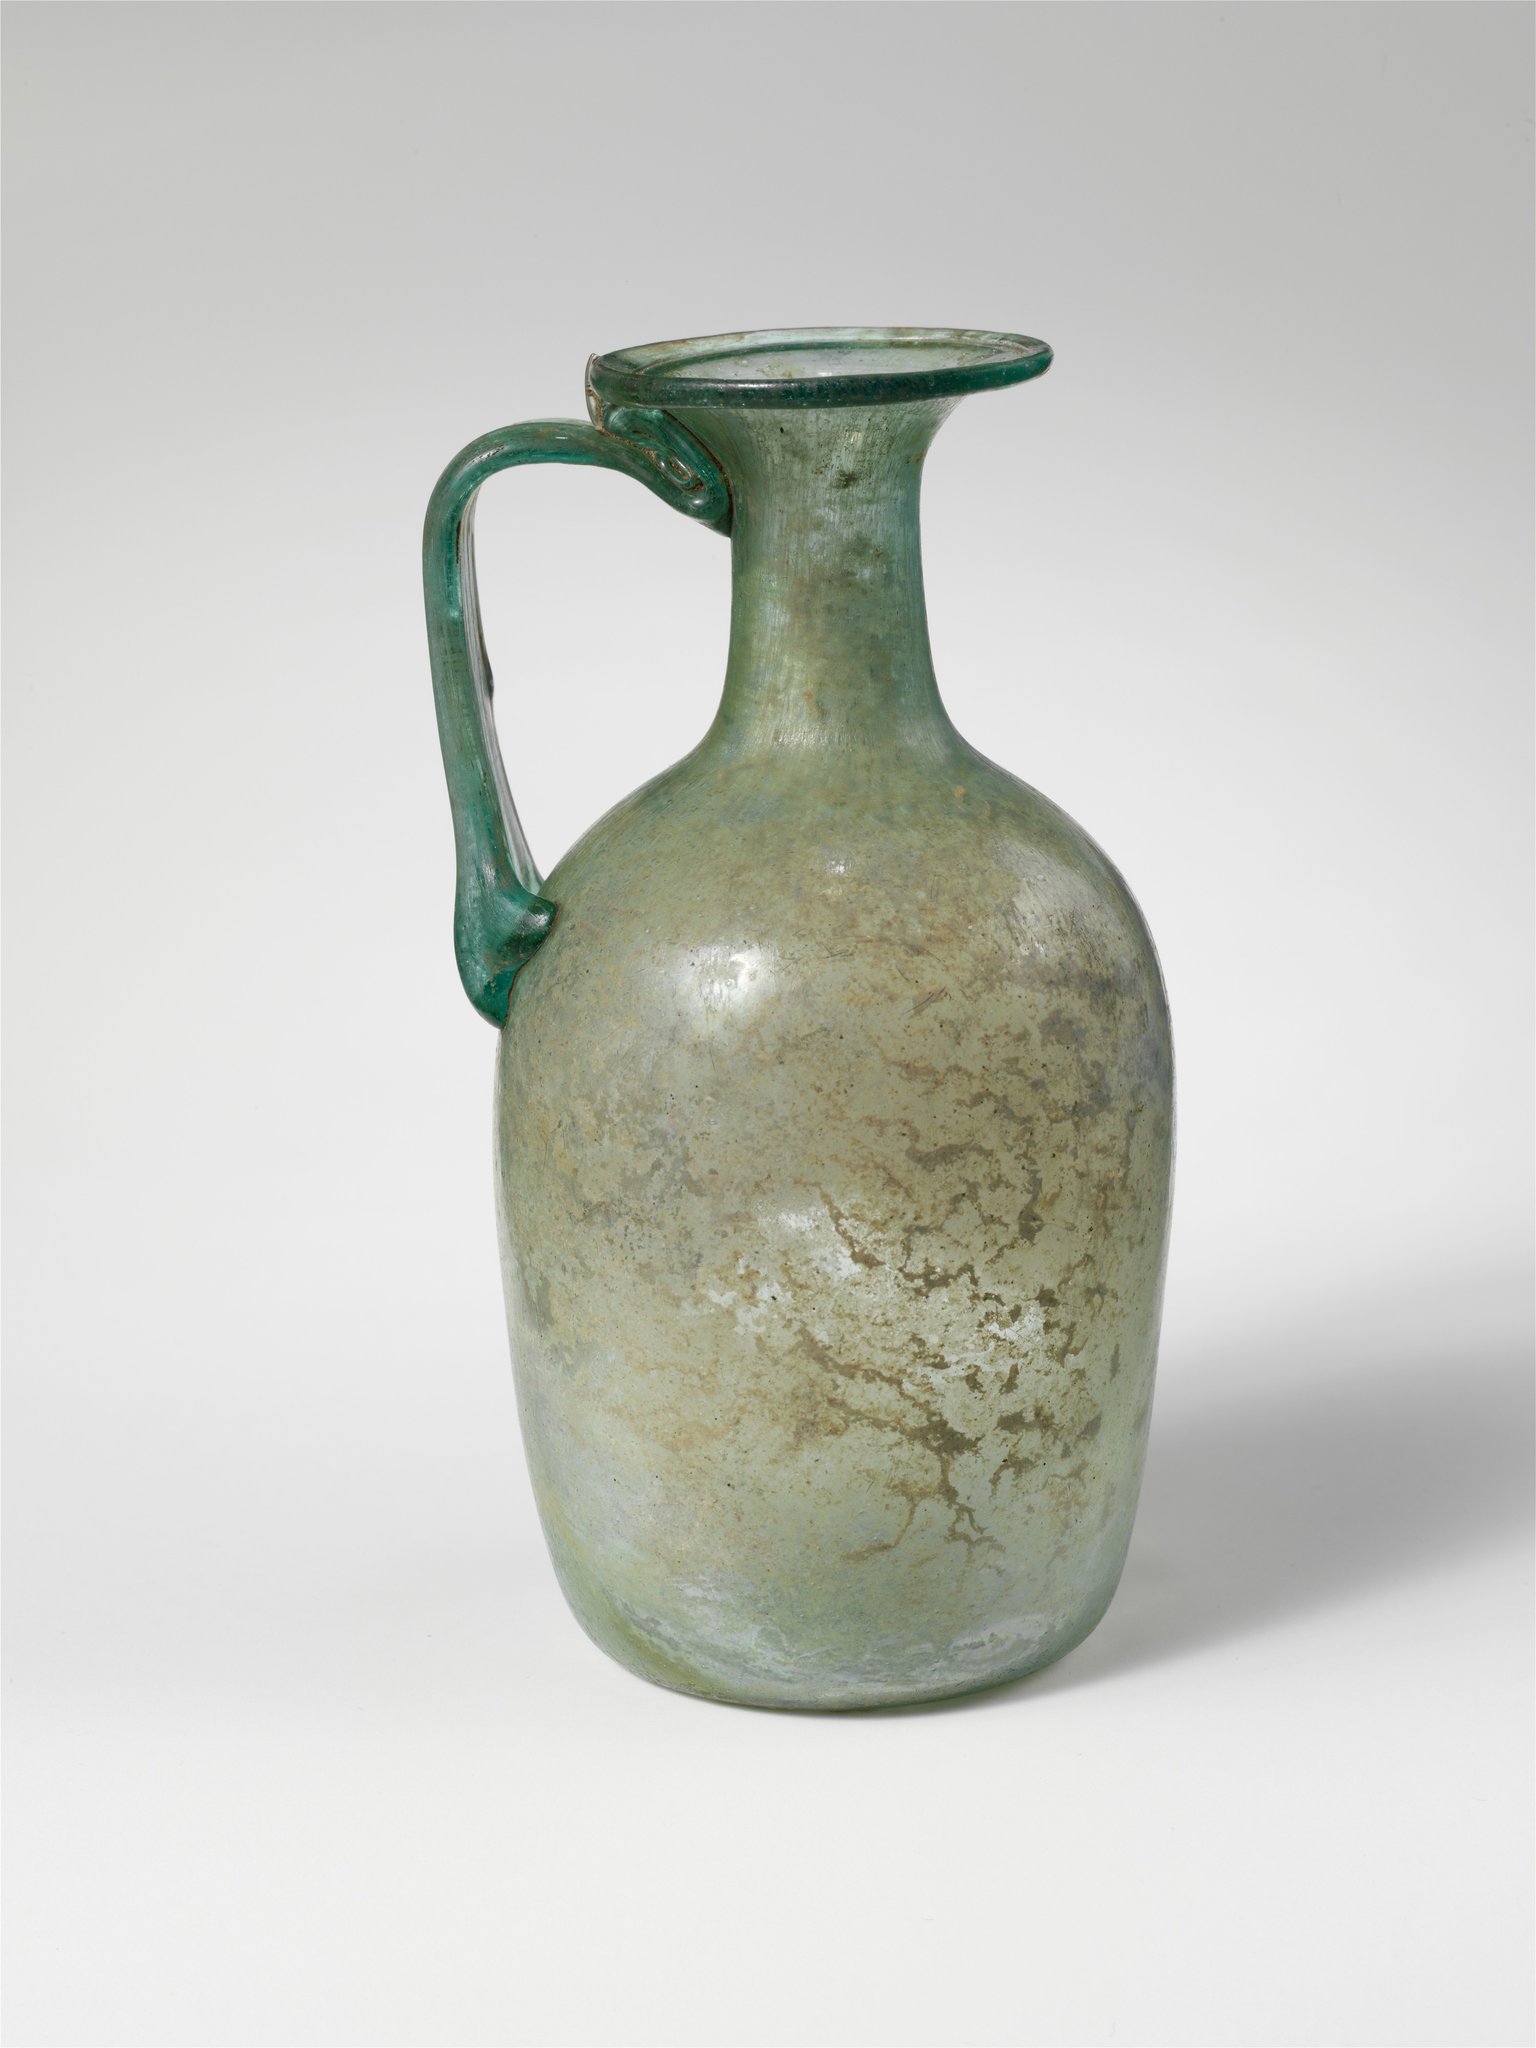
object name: jug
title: Glass jug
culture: roman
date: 1-200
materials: glass